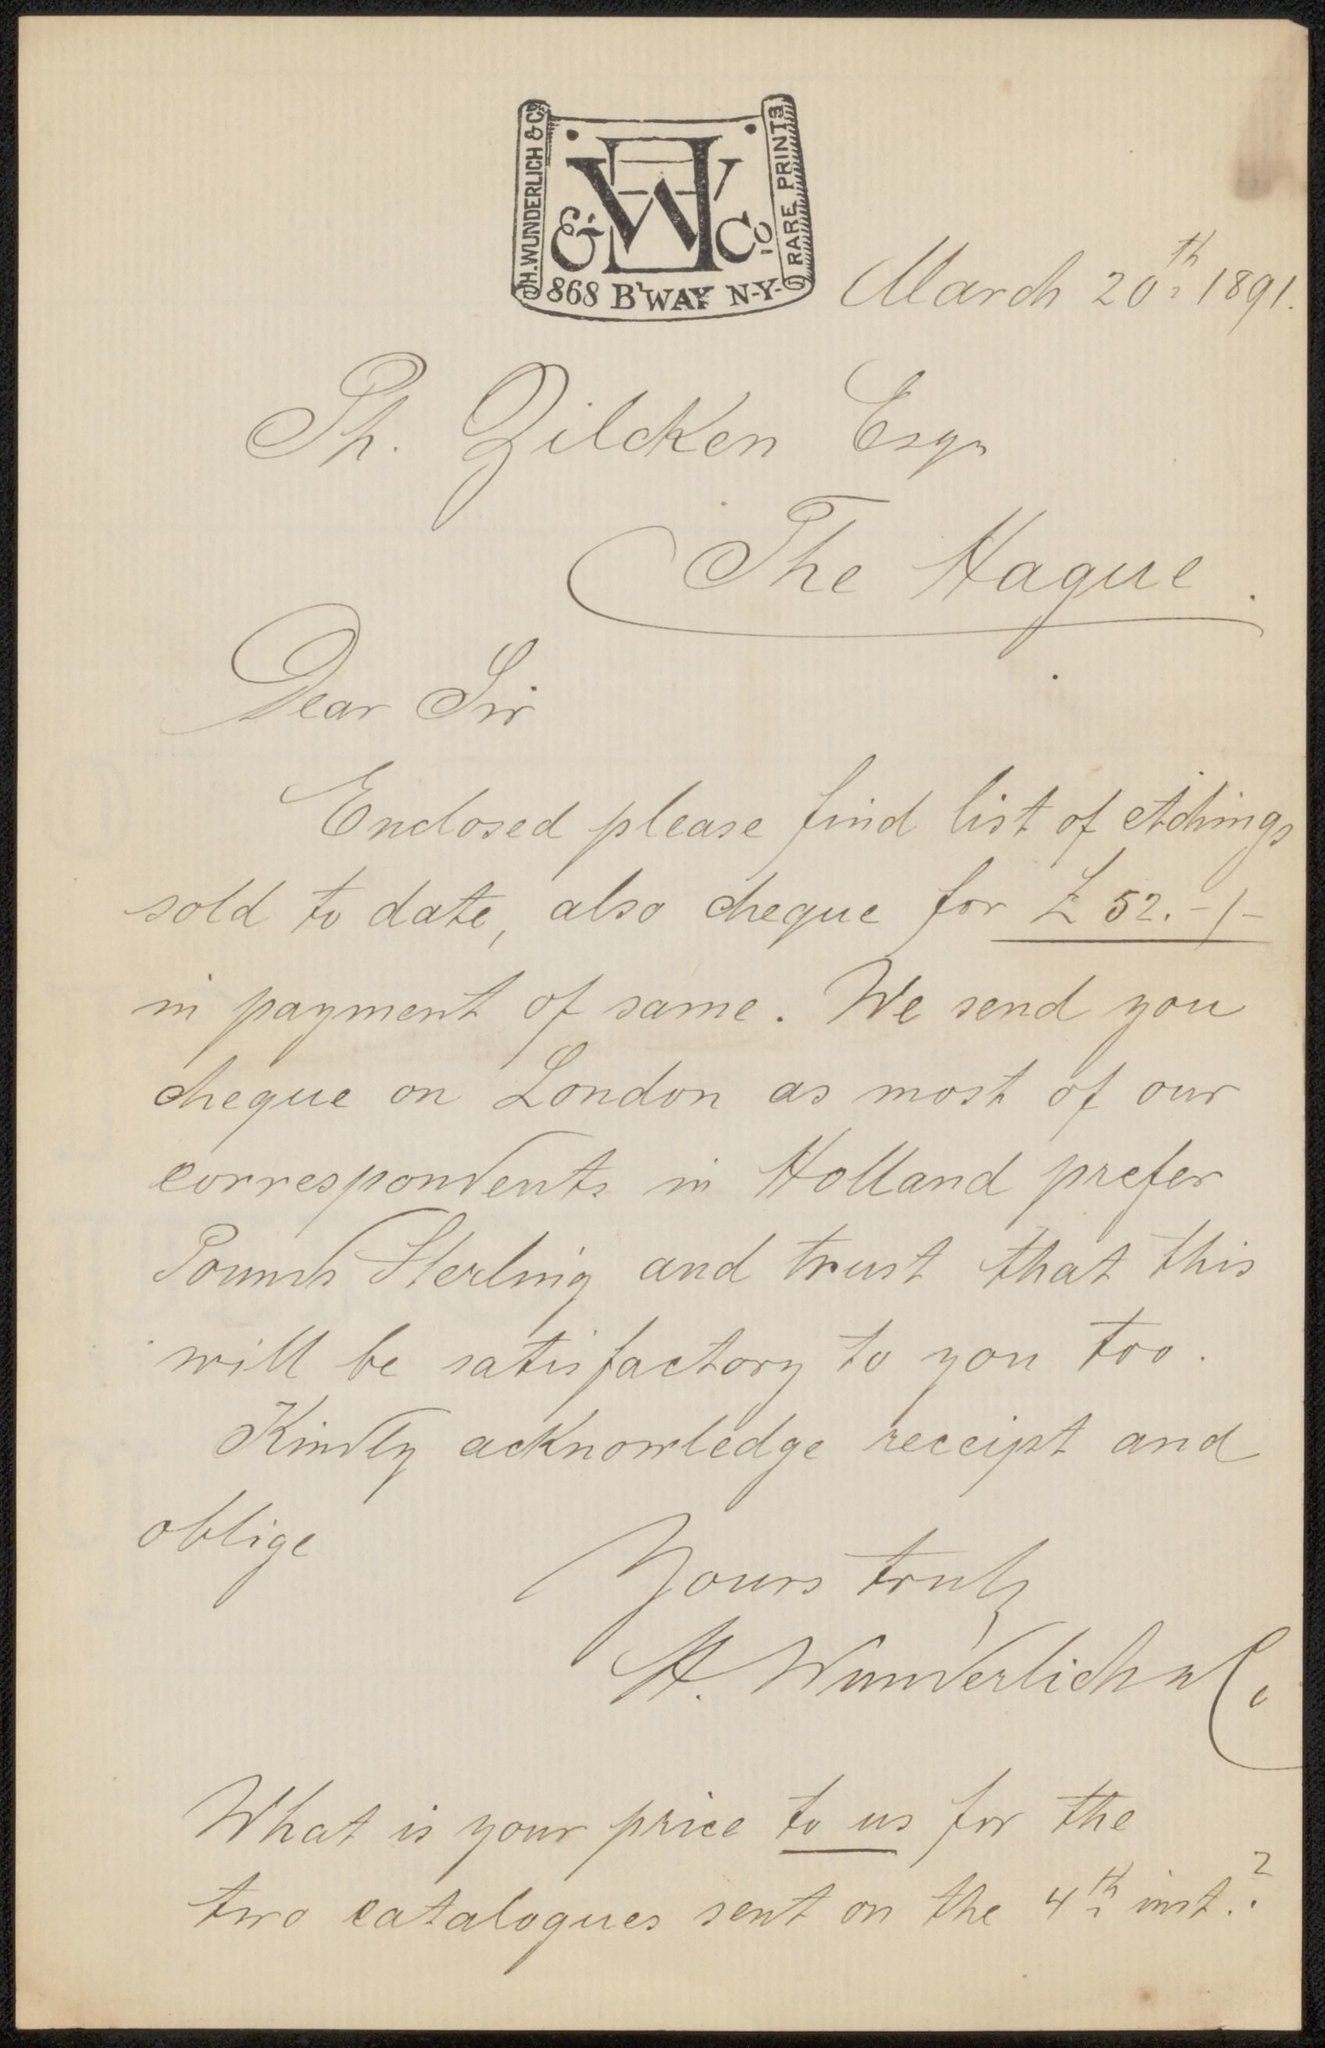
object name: letter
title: Brief aan Philip Zilcken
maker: hermann wunderlich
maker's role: kunsthandelaar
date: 1891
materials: ink, paper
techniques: pen, printing, writing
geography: new york city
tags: the hague, painter, draughtsman, philip zilcken, art trade, art shop, the graphic arts, money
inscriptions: watermark